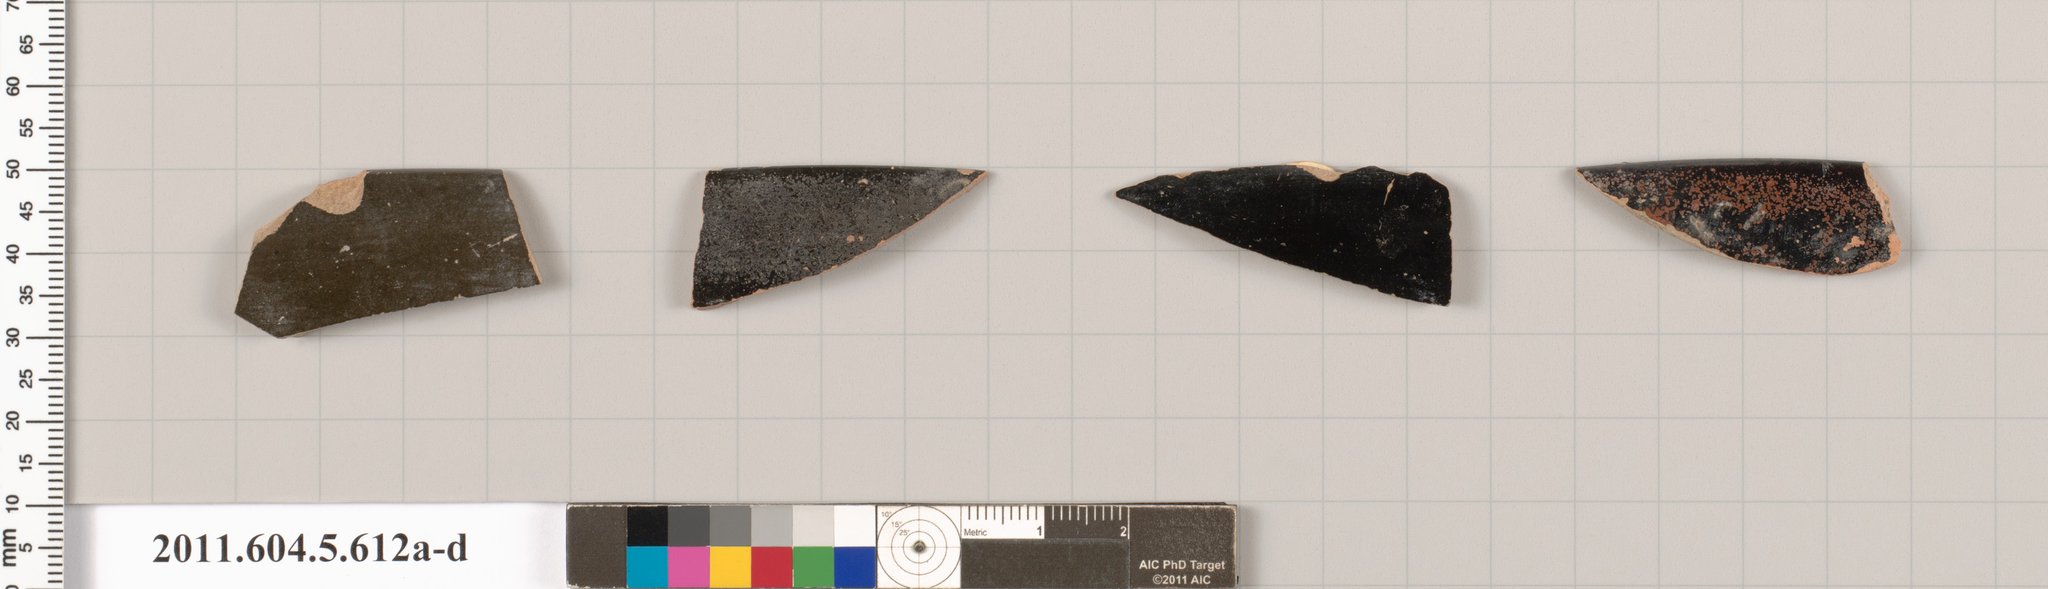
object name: kylix fragment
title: Terracotta rim fragments of kylikes (drinking cups)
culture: greek, attic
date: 600-401 BCE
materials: terracotta